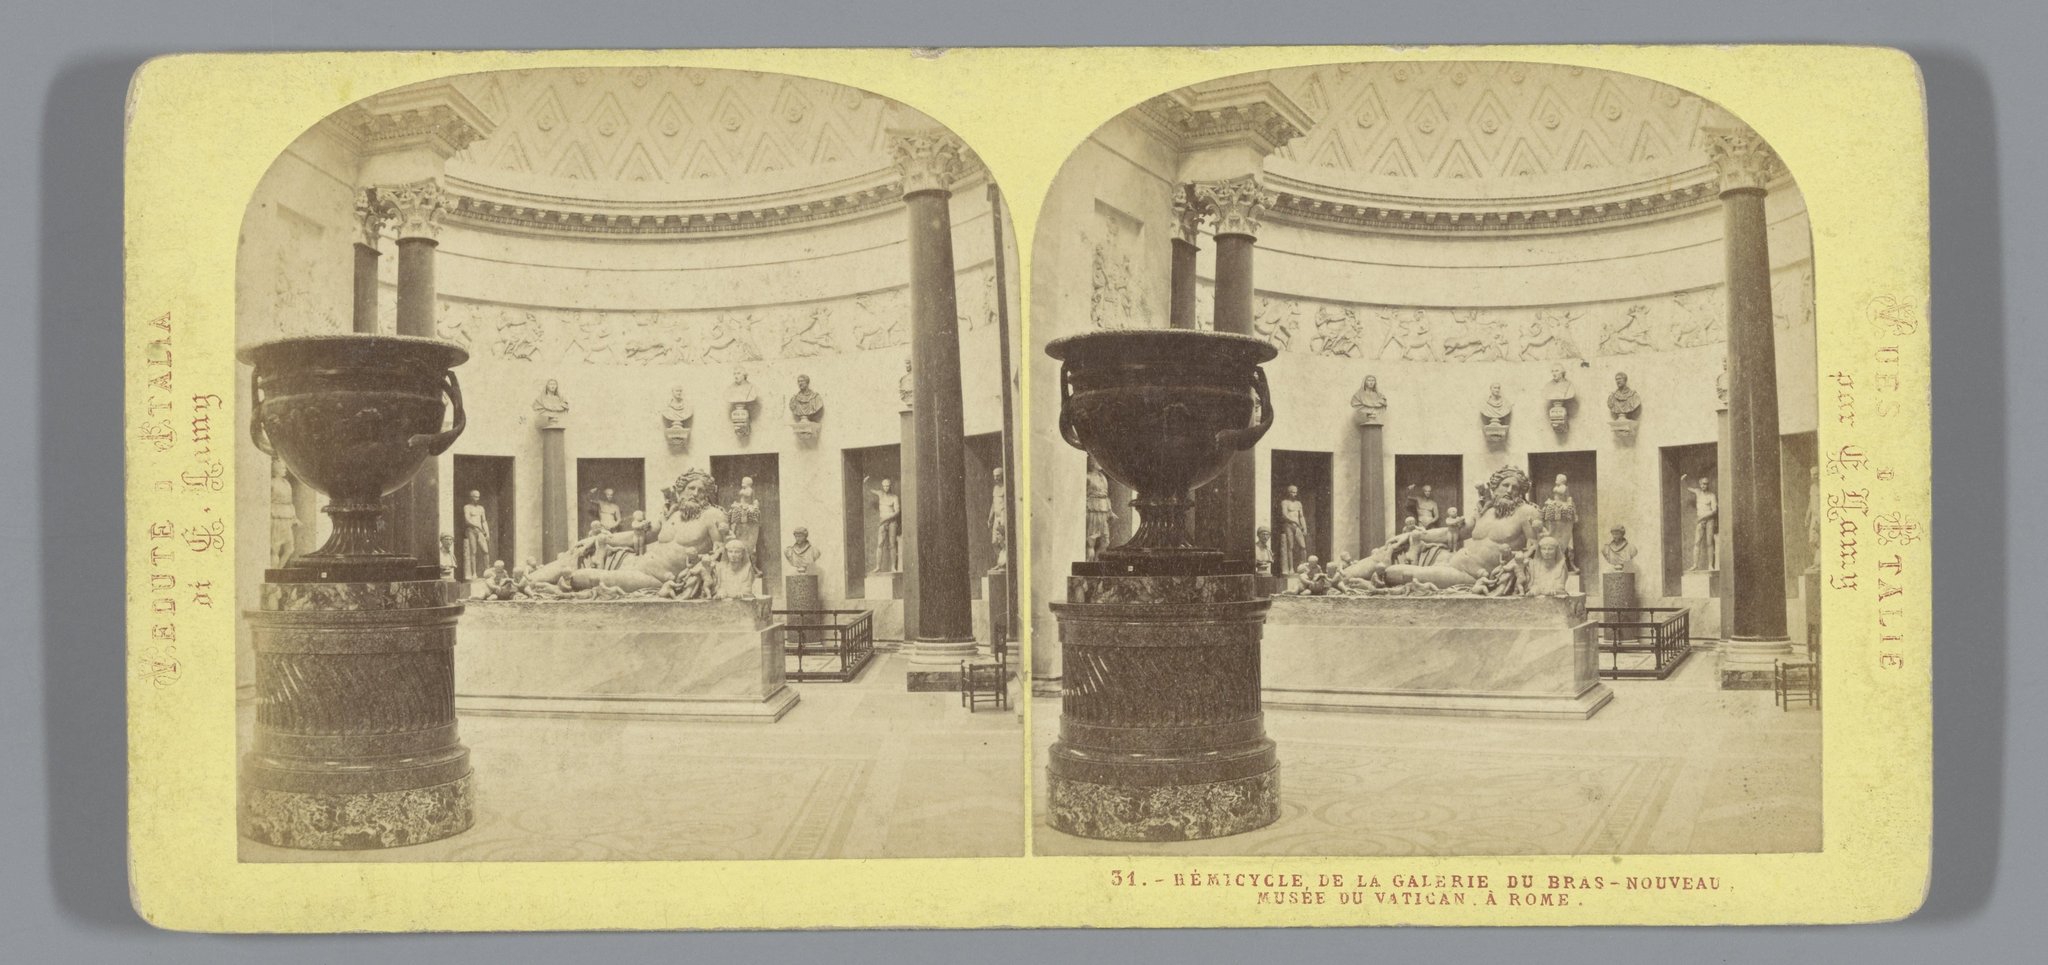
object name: stereograph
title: Hémicycle de la Galerie du Bras-Nouveau, Musée du Vatican, à Rome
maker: ernest eléonor pierre lamy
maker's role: publisher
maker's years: 1828-1900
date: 1861-1878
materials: cardboard, paper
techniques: albumen print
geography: vatican city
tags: gallery of sculptures, permanent exhibition, museum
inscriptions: number: ‘31.’